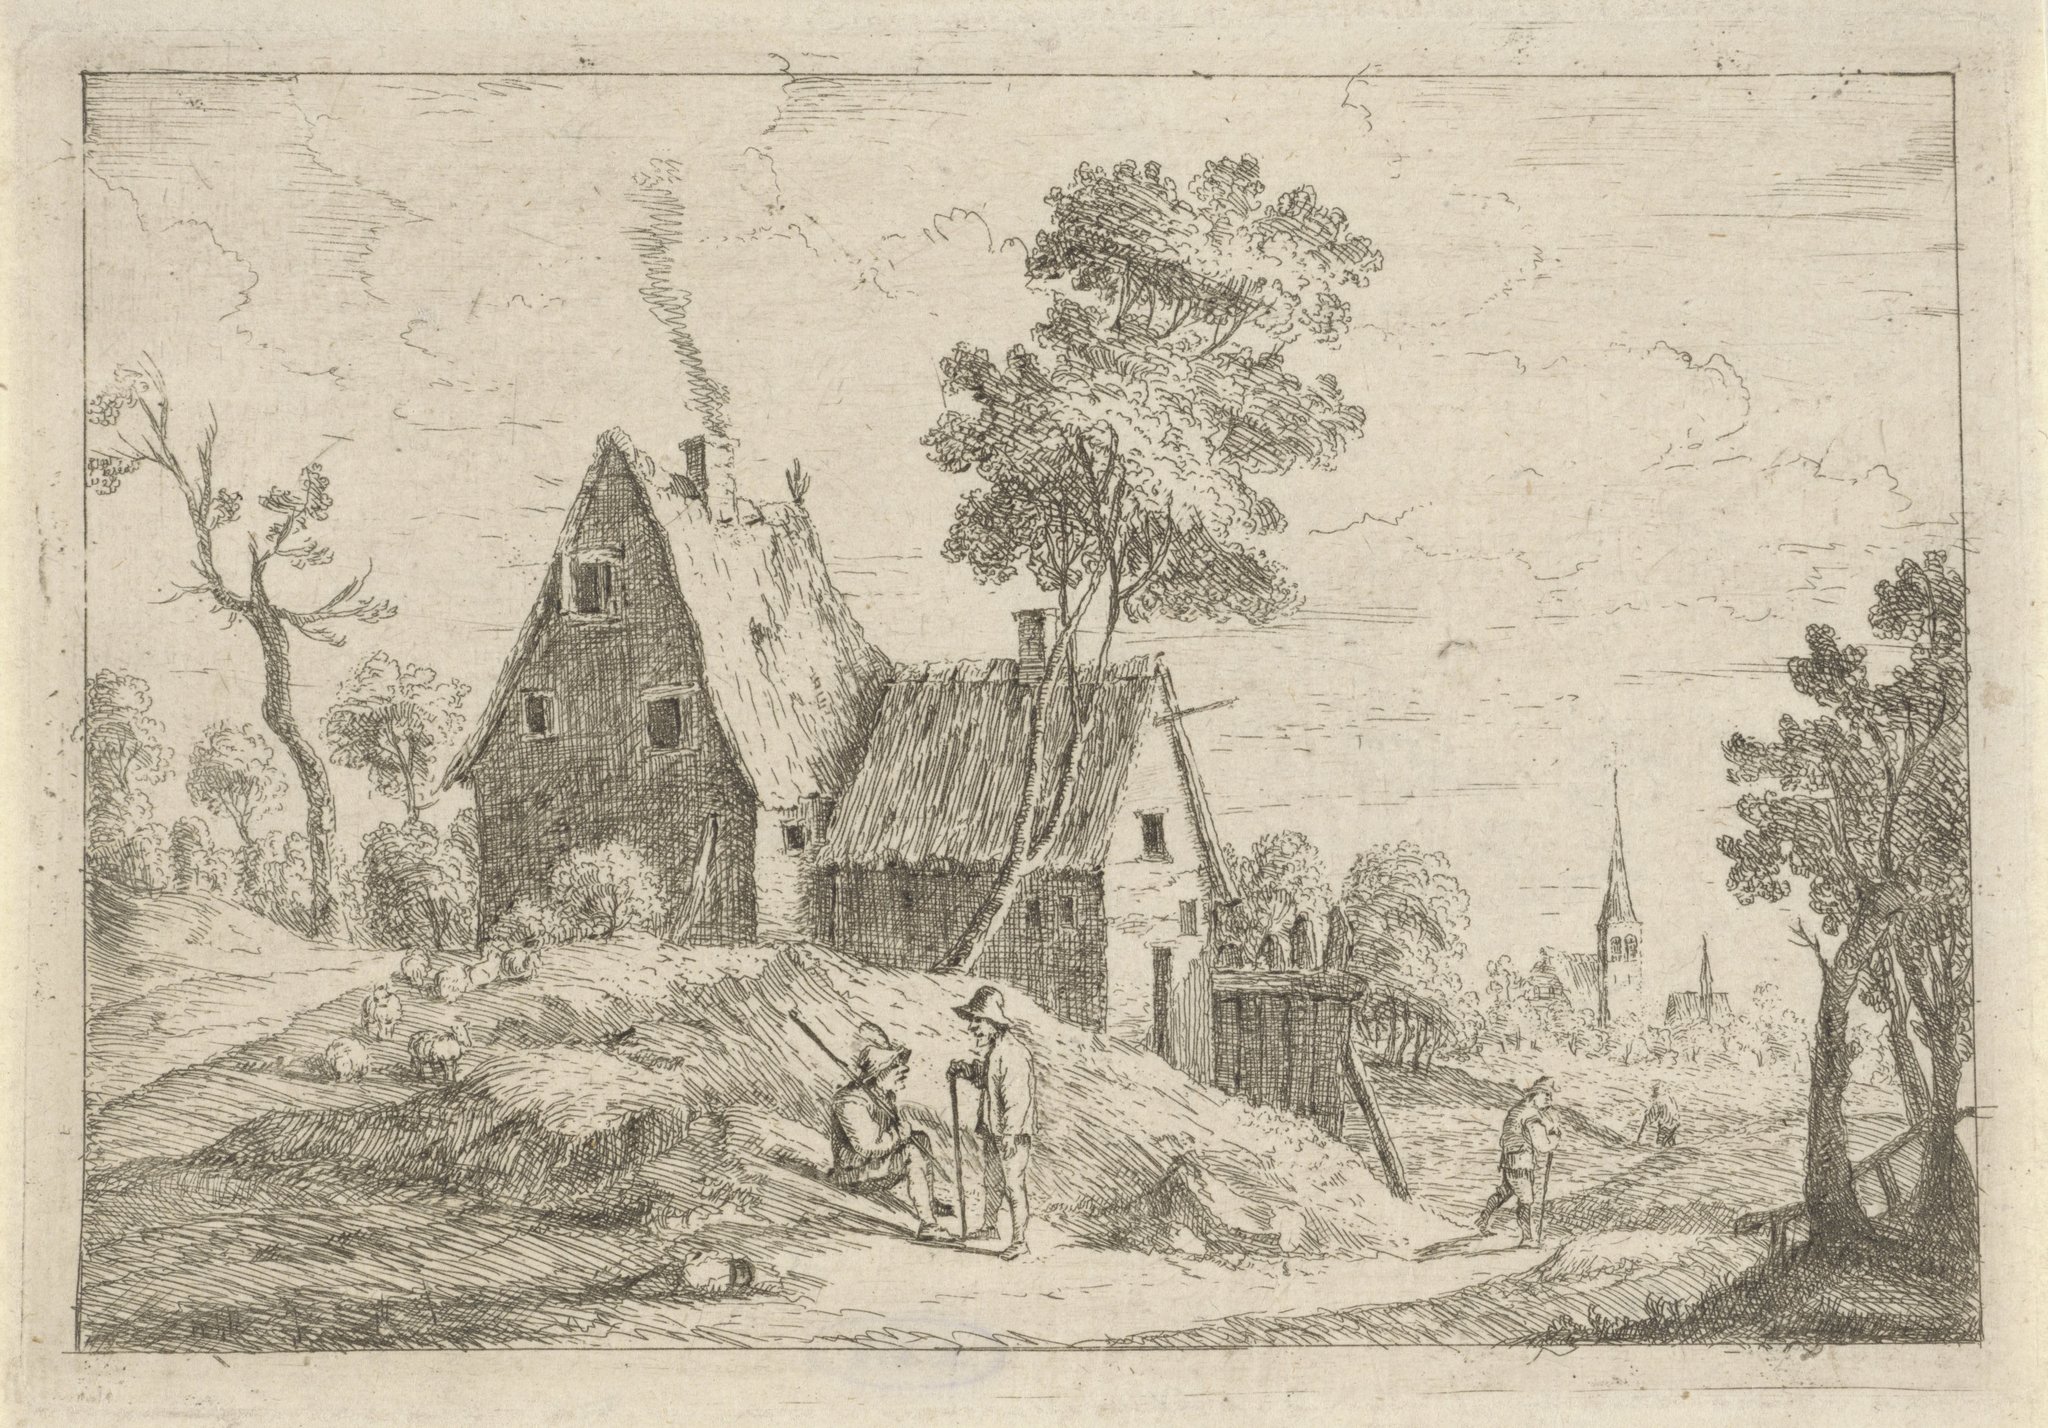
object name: print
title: Landschap met een woning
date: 1700-1850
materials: paper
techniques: etching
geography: low countries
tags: conversation, dialogue; conversation piece, farm or solitary house in landscape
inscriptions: collector's mark: Lugt 2228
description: Landschap met twee mannen in gesprek bij een woning. In de verte een kerktoren.